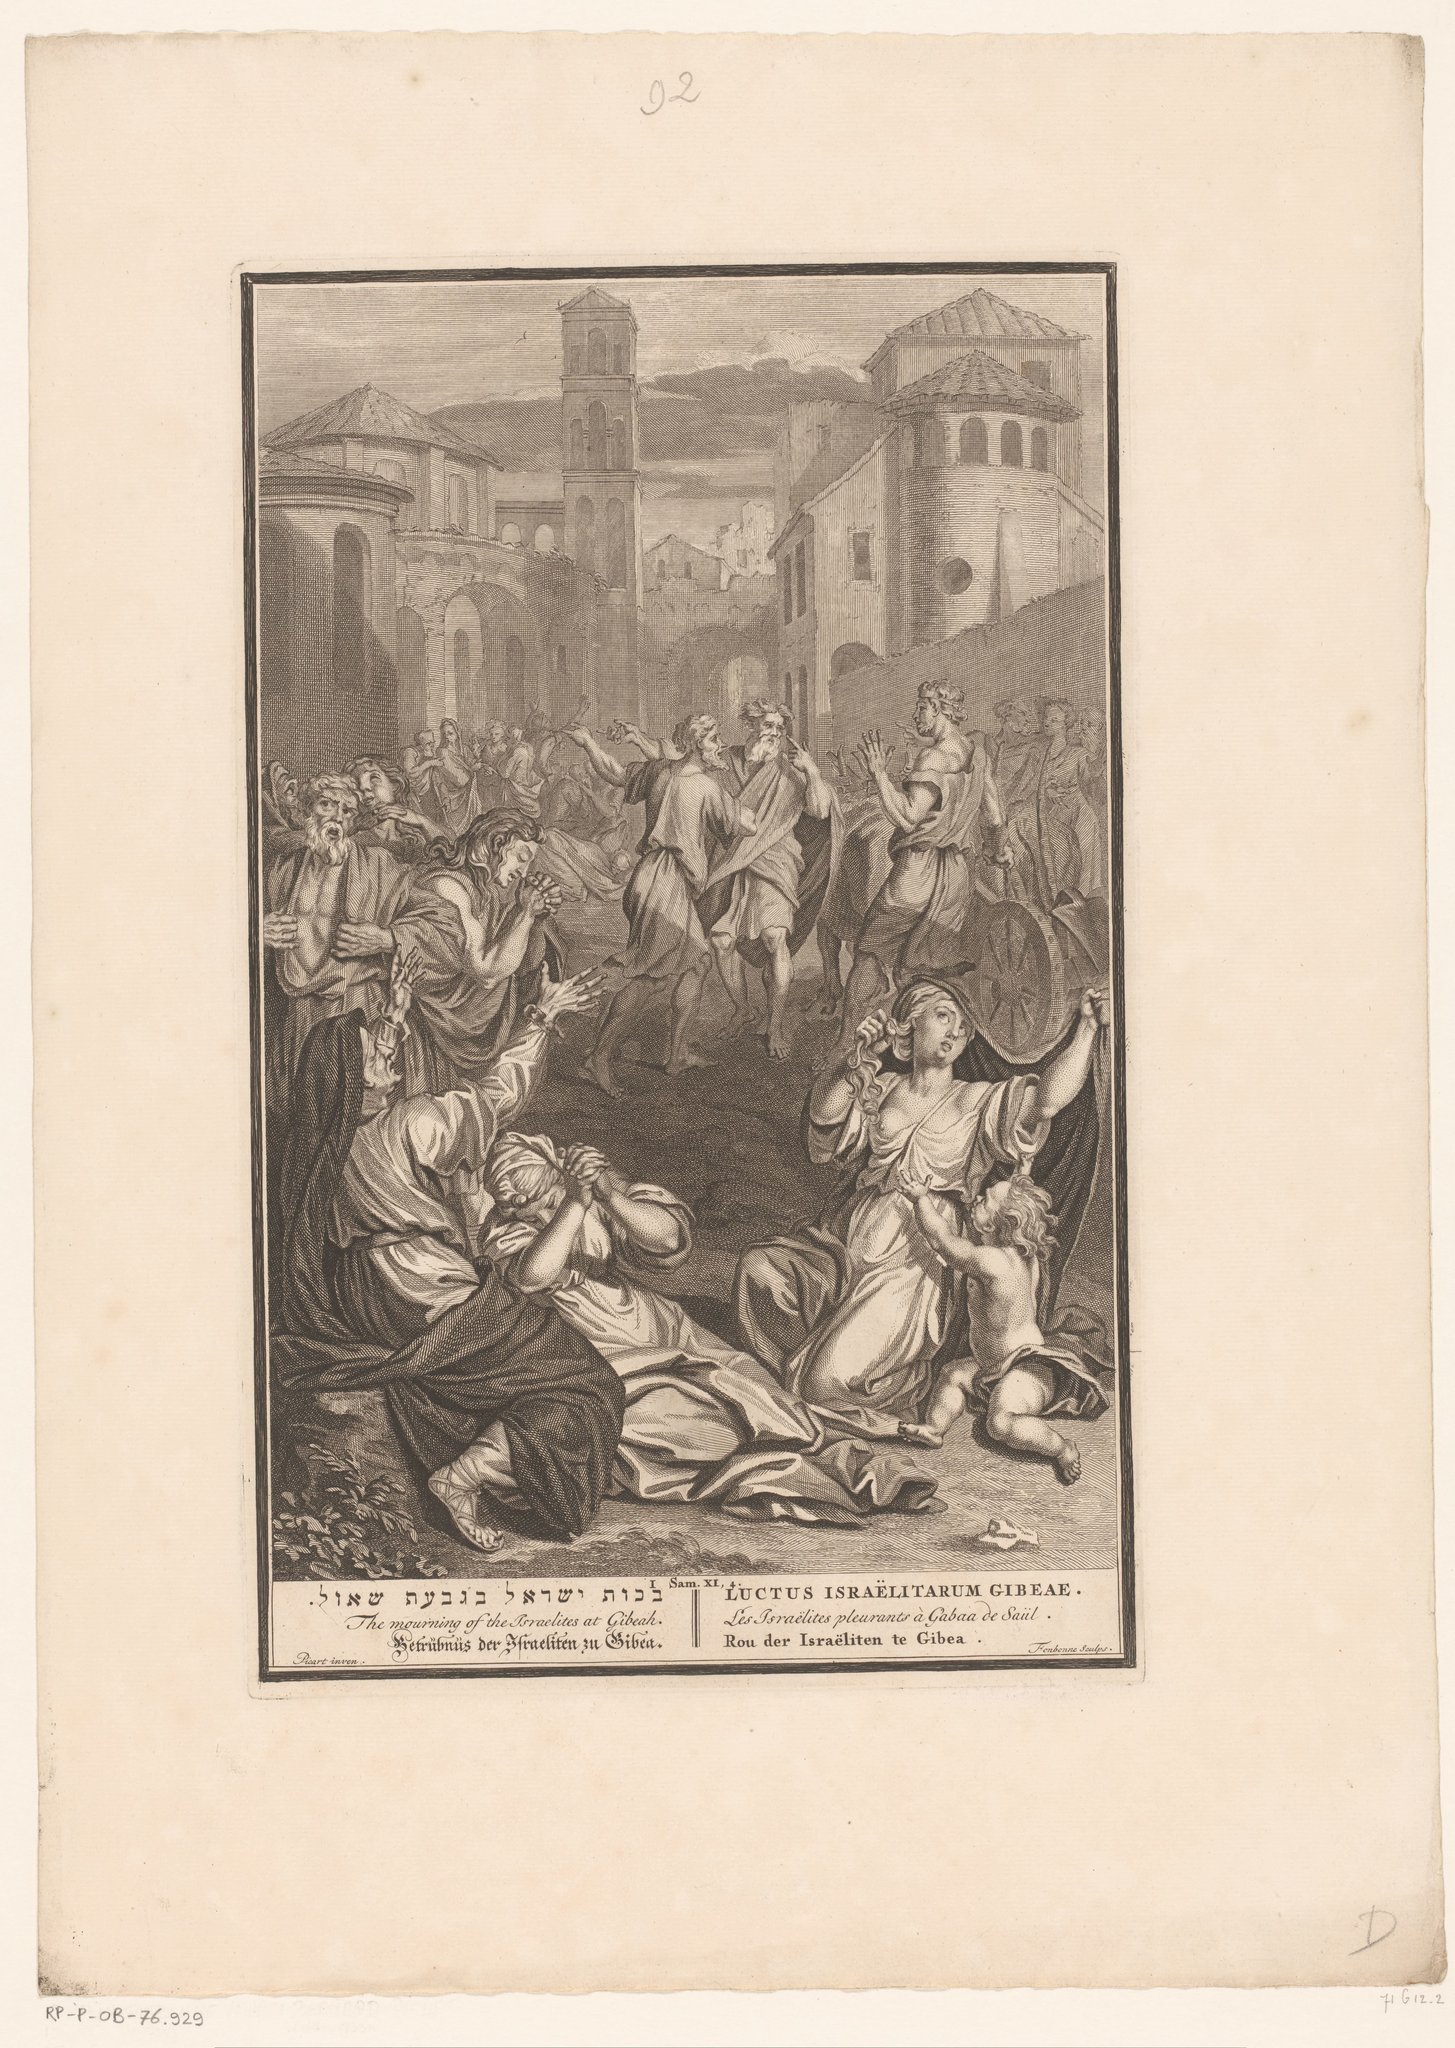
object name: print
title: Rouw der Israëlieten te Gibea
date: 1690-1757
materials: paper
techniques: engraving, etching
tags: messengers of jabesh-gilead come to gibeah; the people weep on hearing the news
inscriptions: collector's mark: Lugt 2228